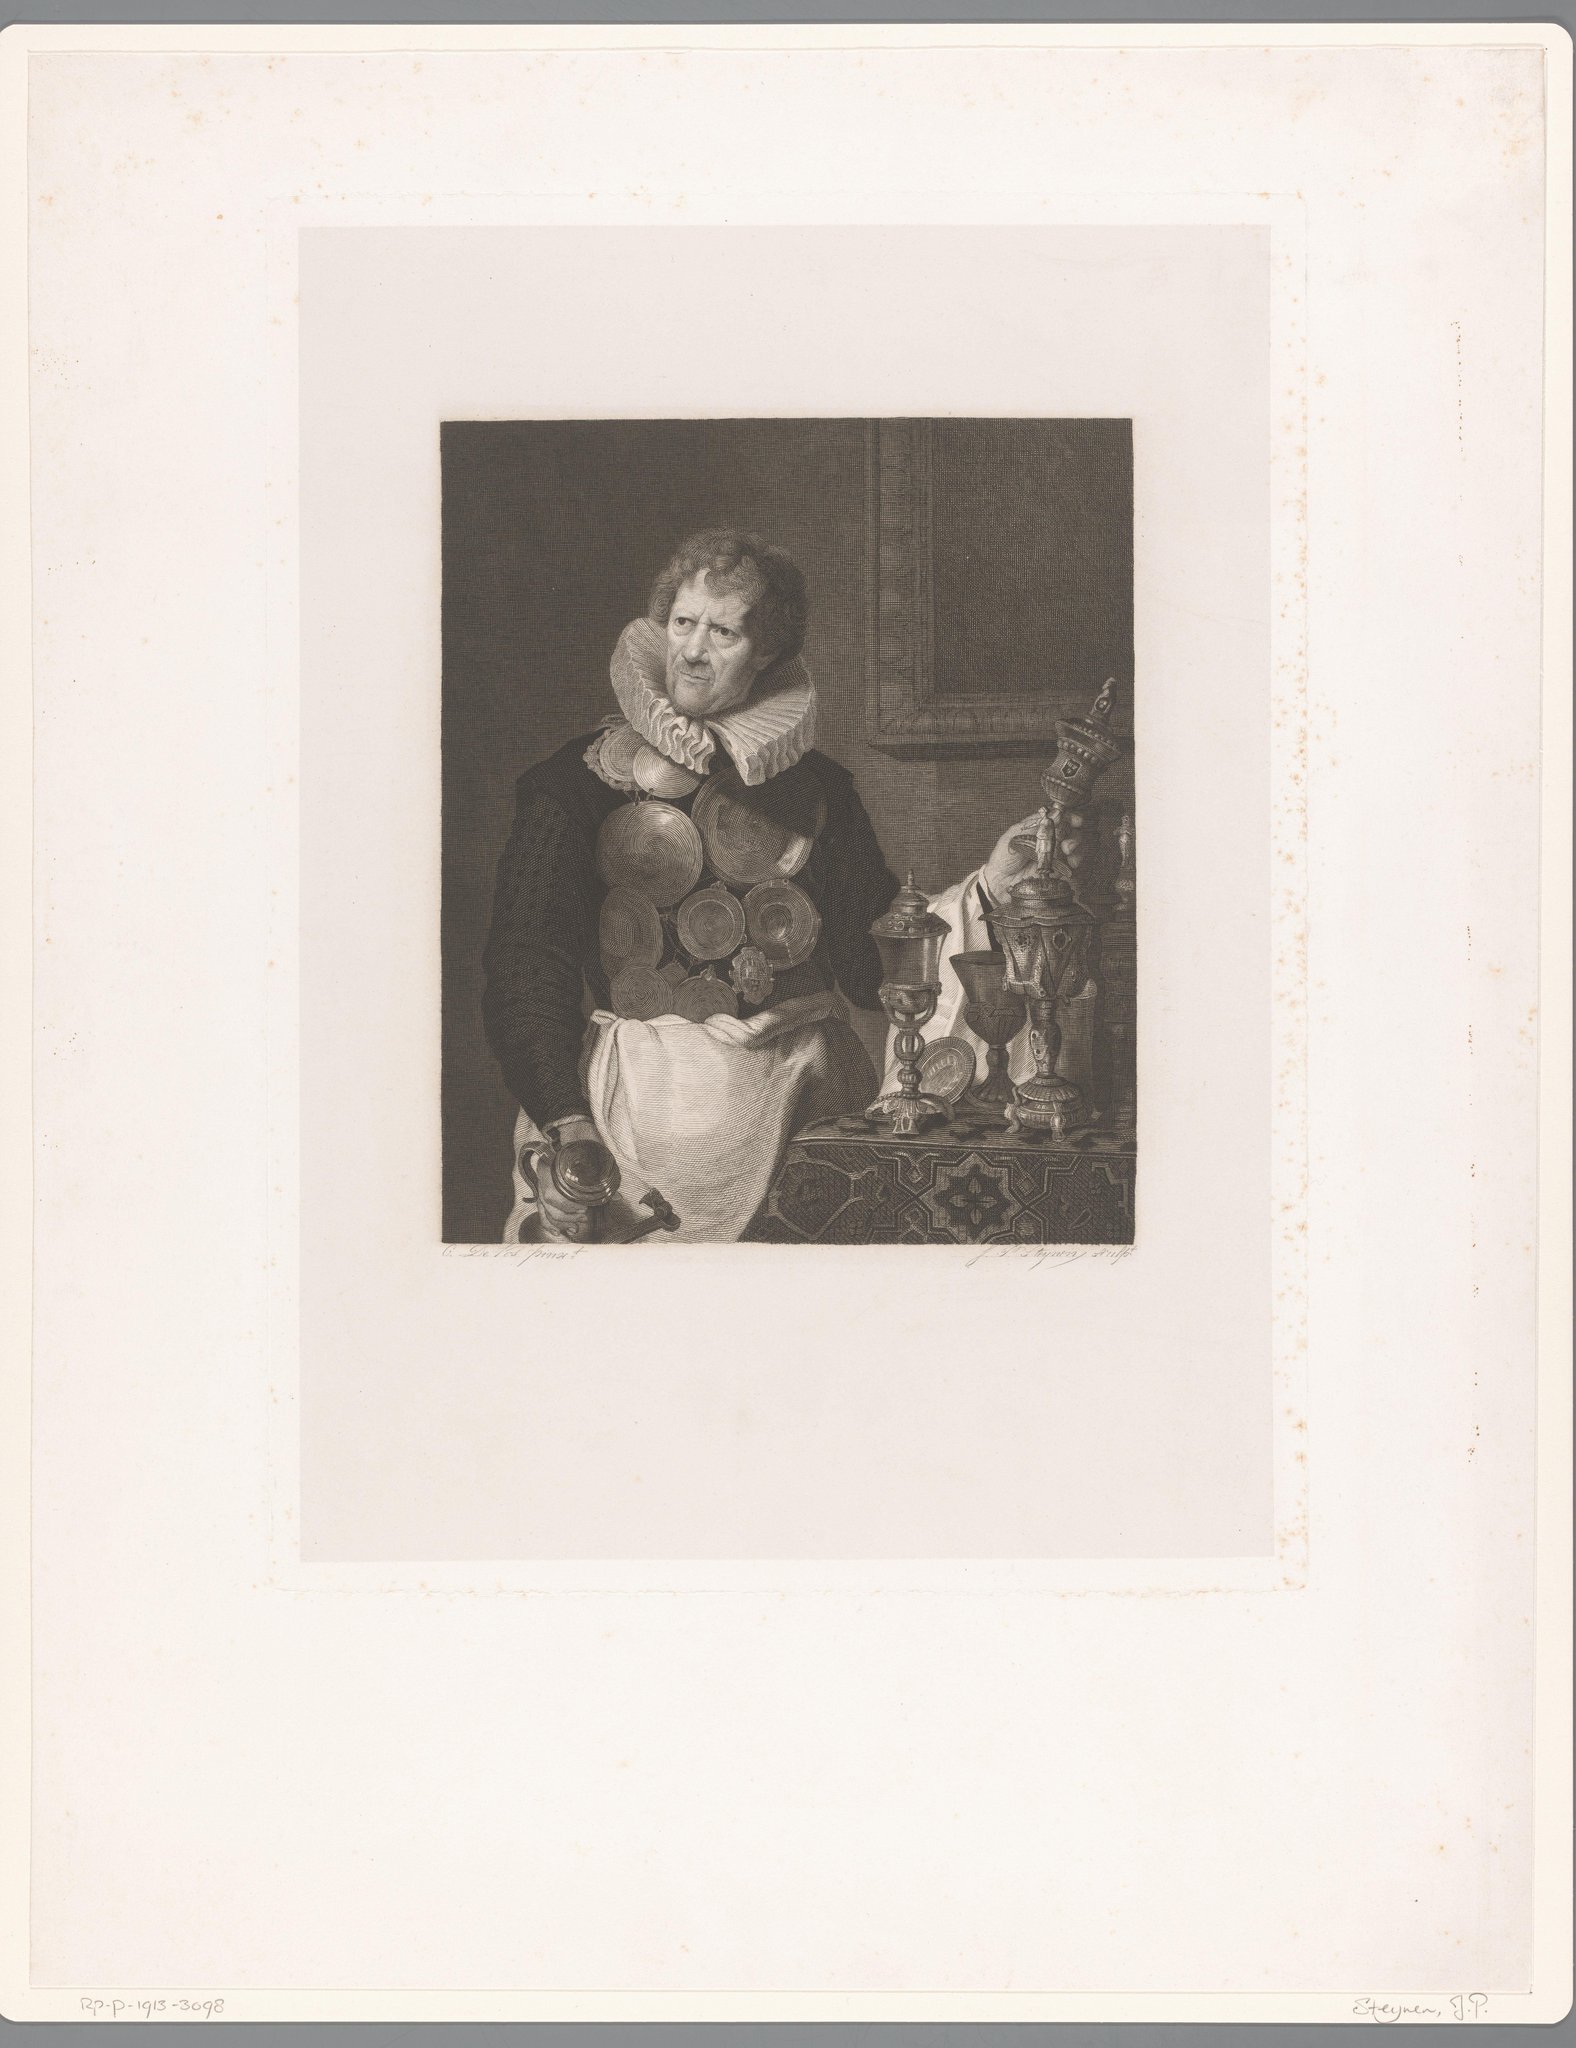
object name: print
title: Portret van Abraham Grapheus bij een tafel met vaatwerk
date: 1850-1913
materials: paper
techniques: engraving, etching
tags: historical persons, mug, beaker, goblet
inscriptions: collector's mark: Lugt 2228